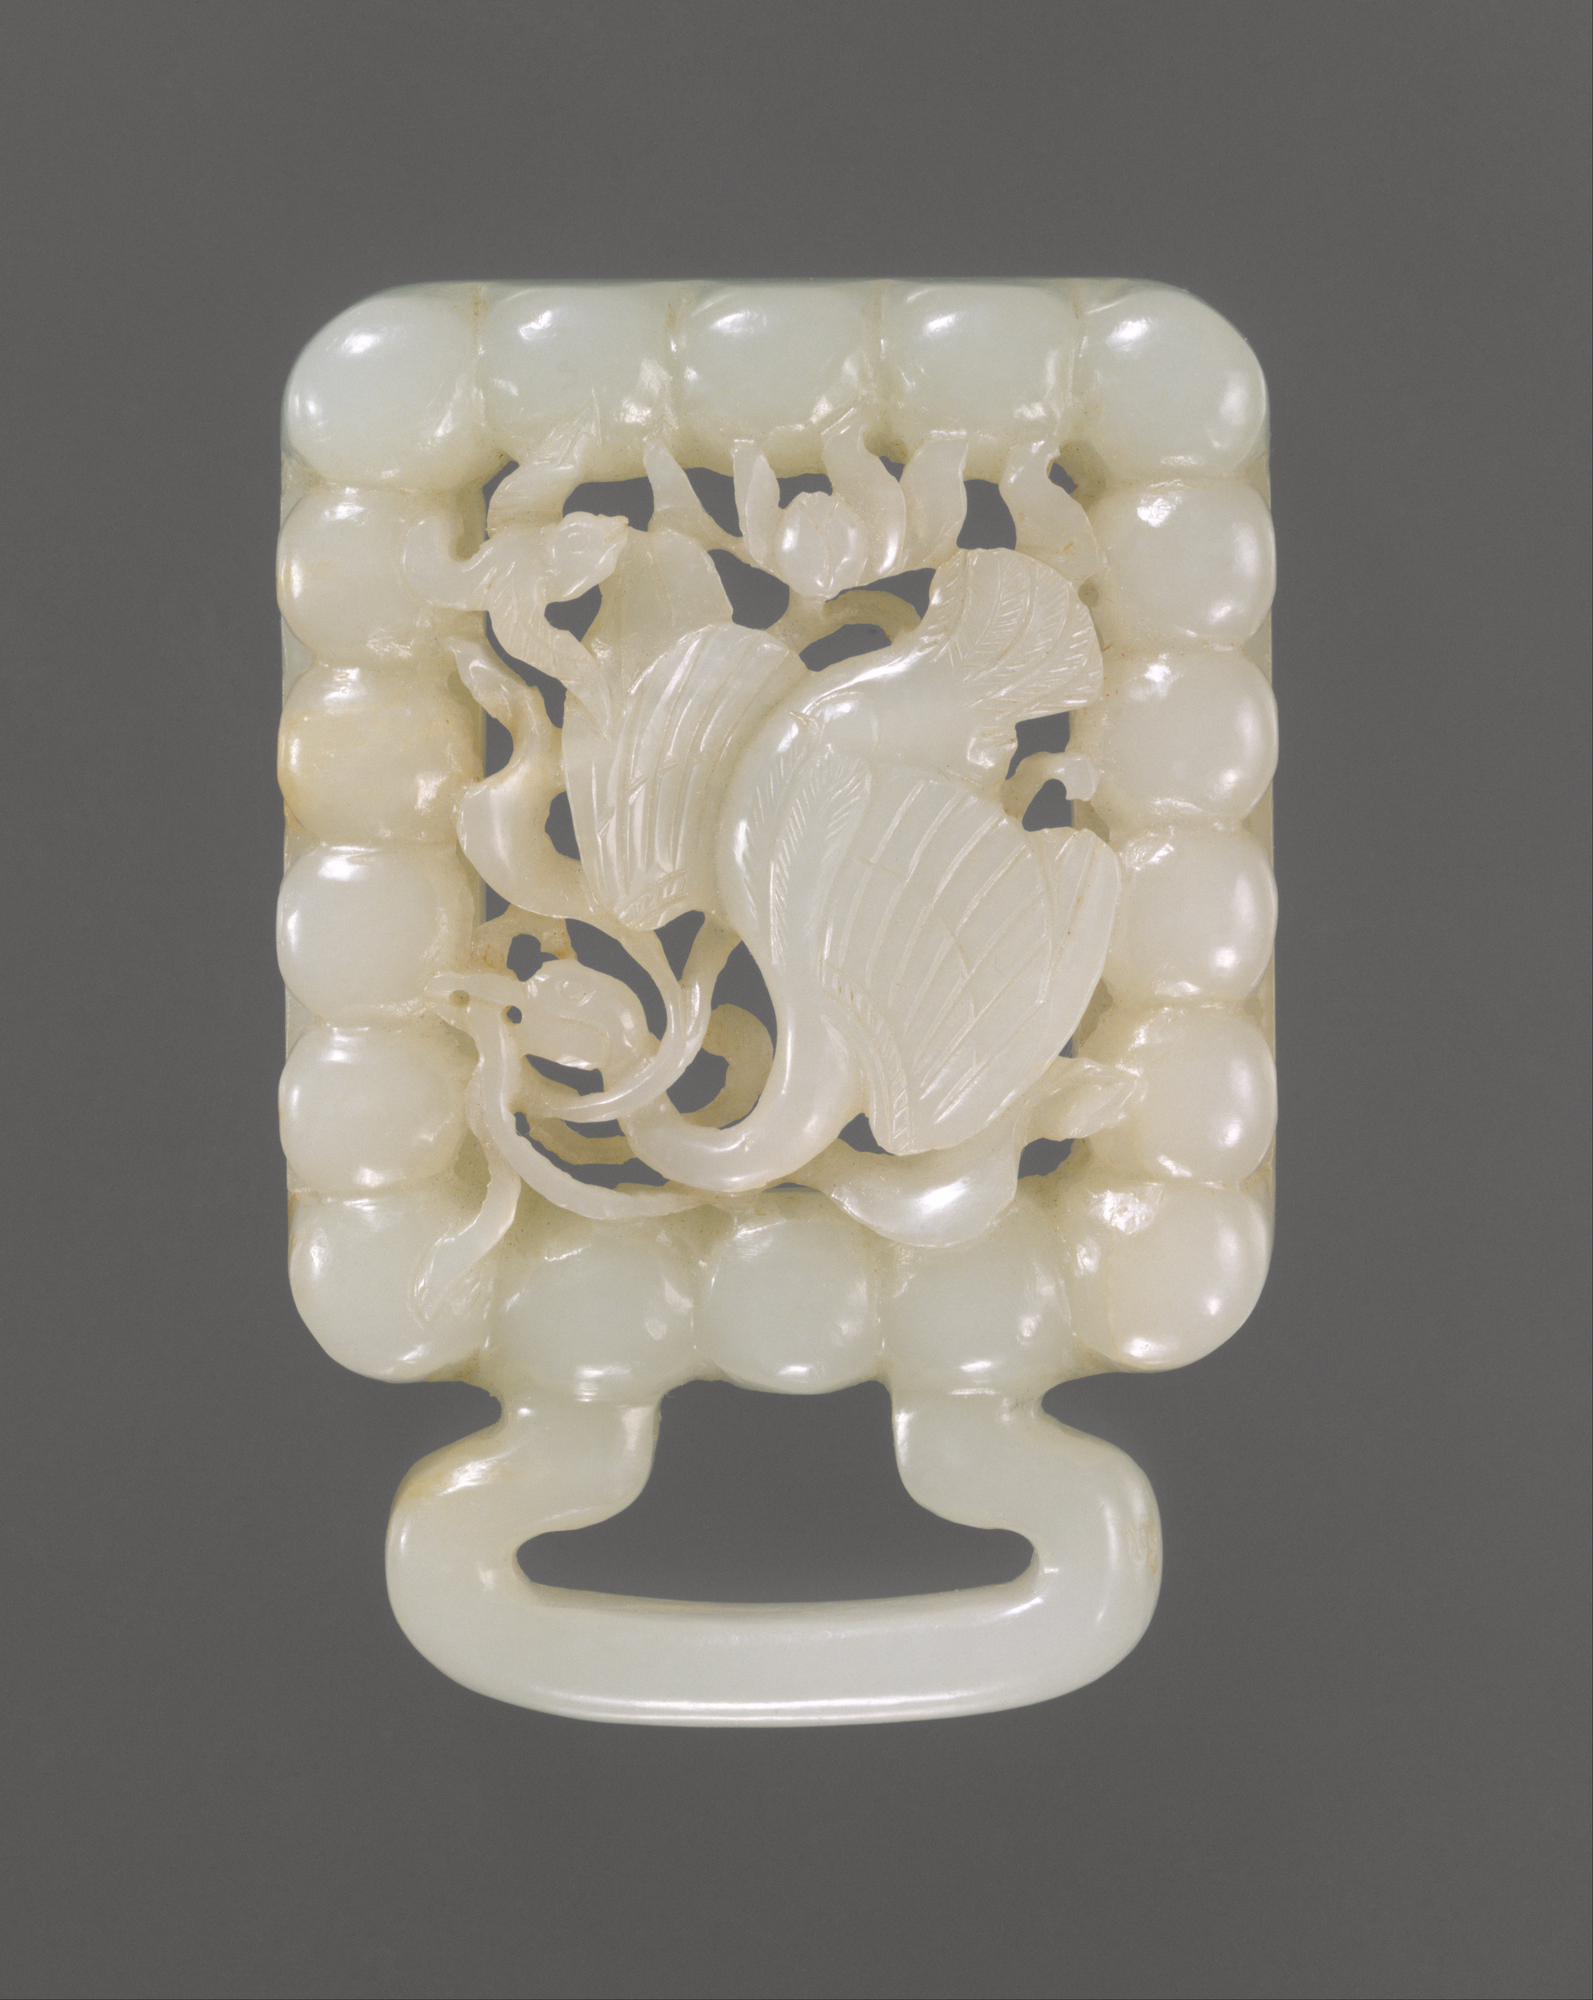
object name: belt slide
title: Belt slide with a falcon attacking a swan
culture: chinese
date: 1101-1400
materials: jade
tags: birds